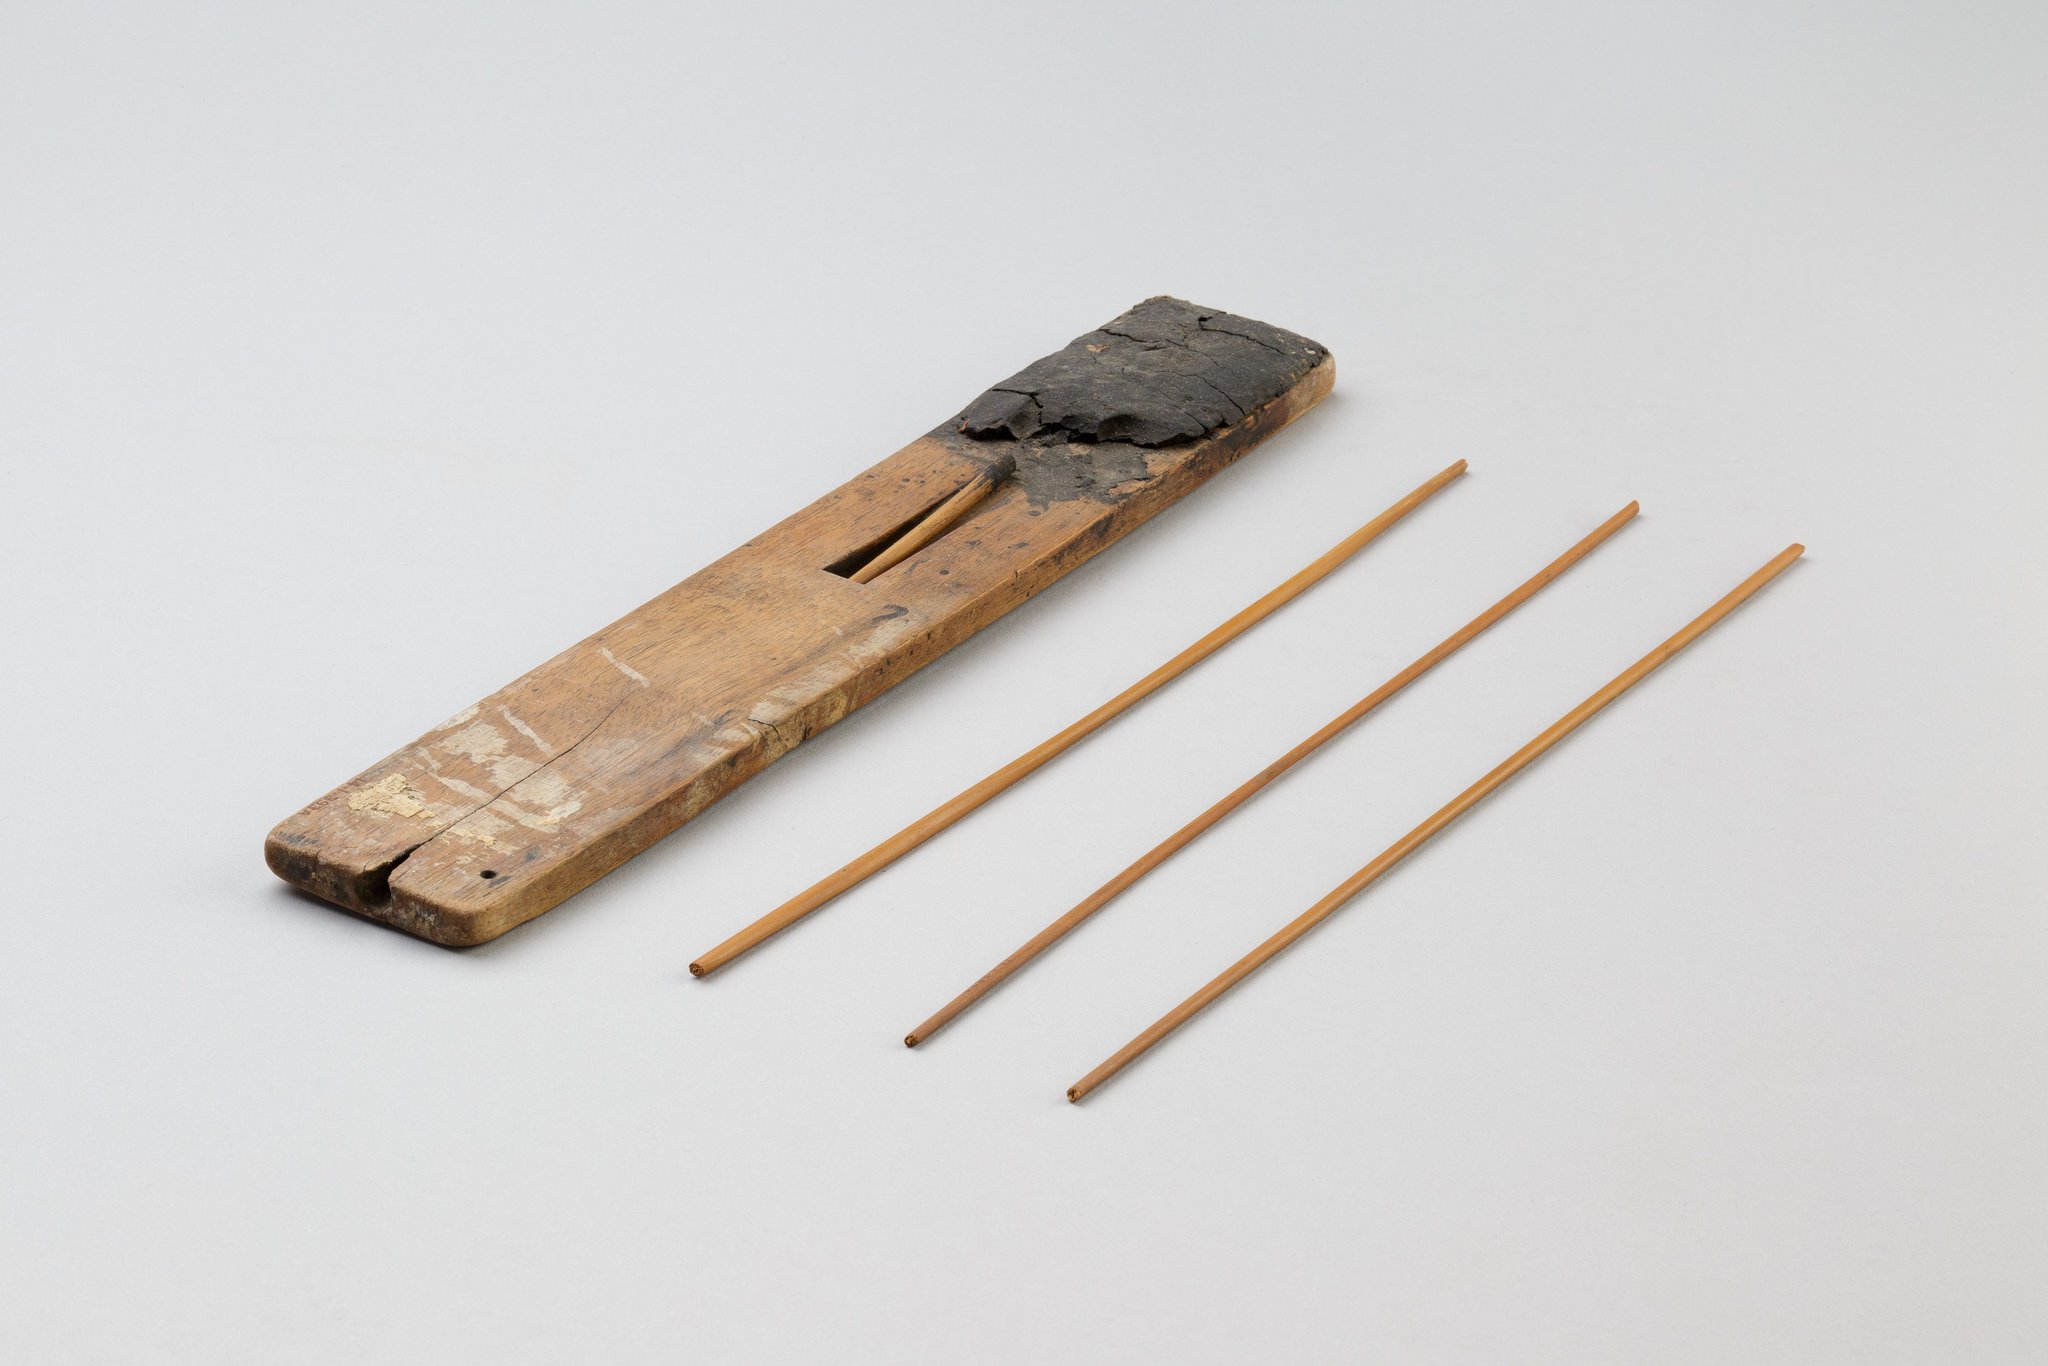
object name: palette and brush, scribe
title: Scribe's Palette and Brushes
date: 664-332 BCE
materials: ink, wood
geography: egypt